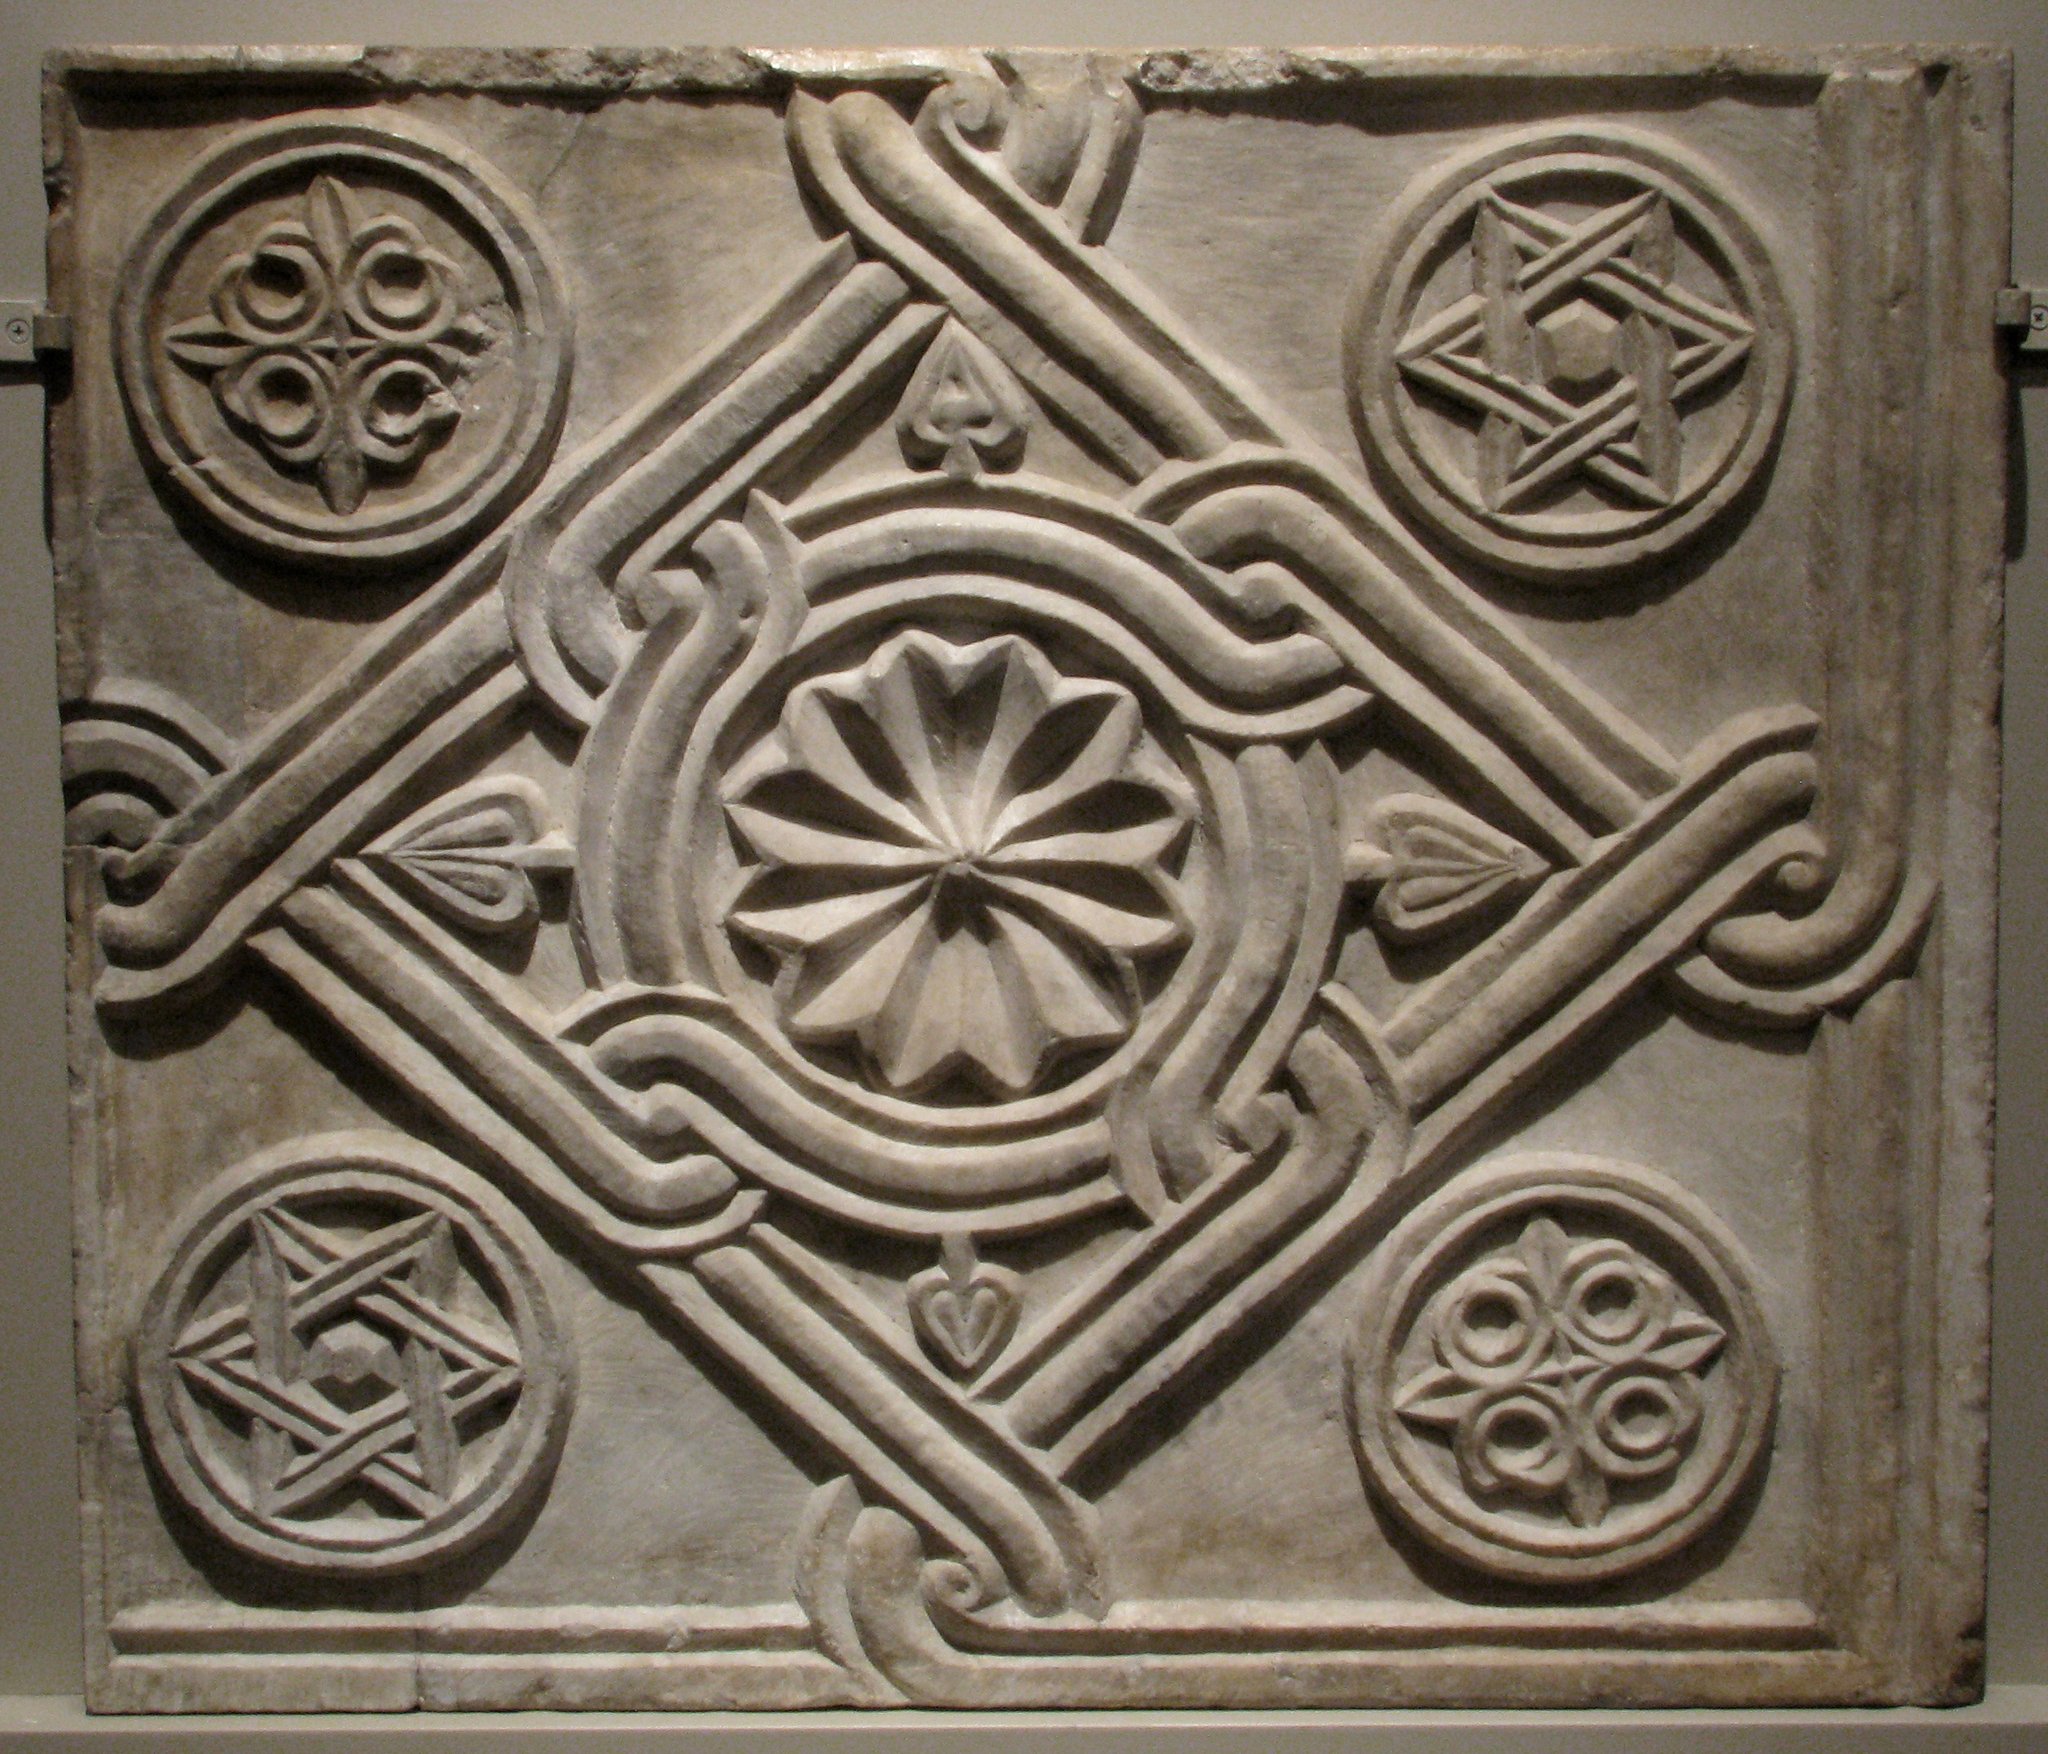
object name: relief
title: Marble Decorative Panels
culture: byzantine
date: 901-1100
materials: marble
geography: possibly constantinople